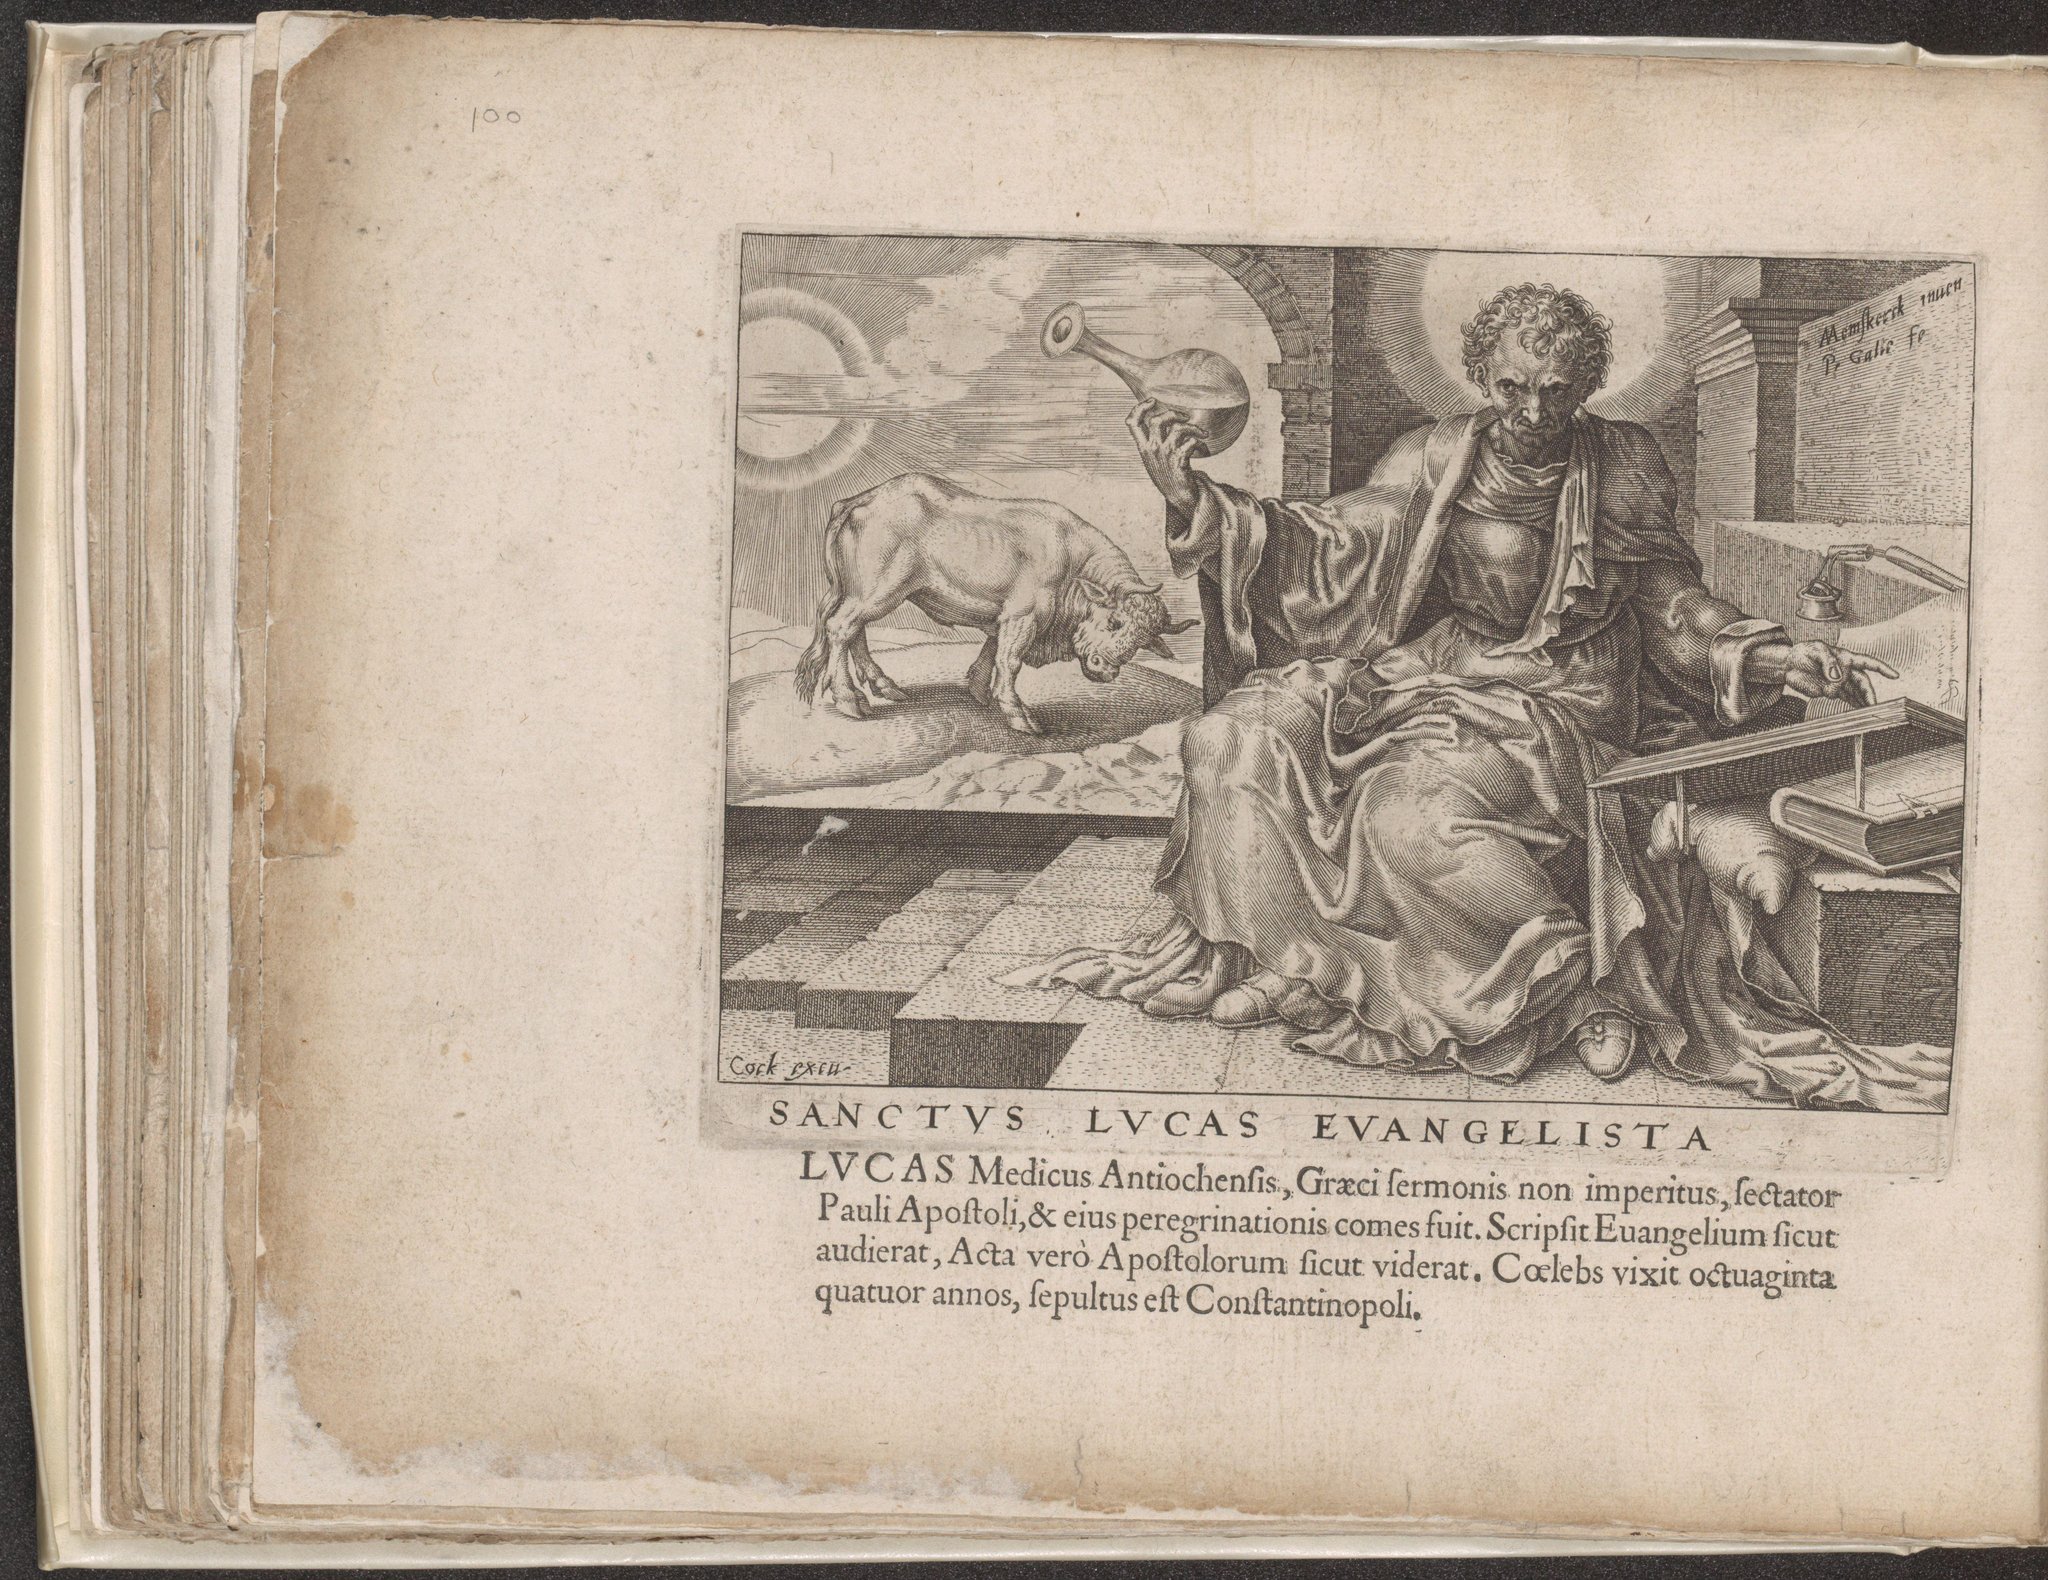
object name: album leaf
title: De vier evangelisten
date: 1562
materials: paper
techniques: engraving, letterpress printing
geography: antwerp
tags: st. luke writing his gospel, usually a (winged) ox present, urinal (and basket)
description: De evangelist Lucas is gekleed als geneesheer en zit met een urinaal in de hand bij zijn evangelie. Links de os. Onder de voorstelling een verklarende tekst in het Latijn. Deze prent maakt deel uit van een album.